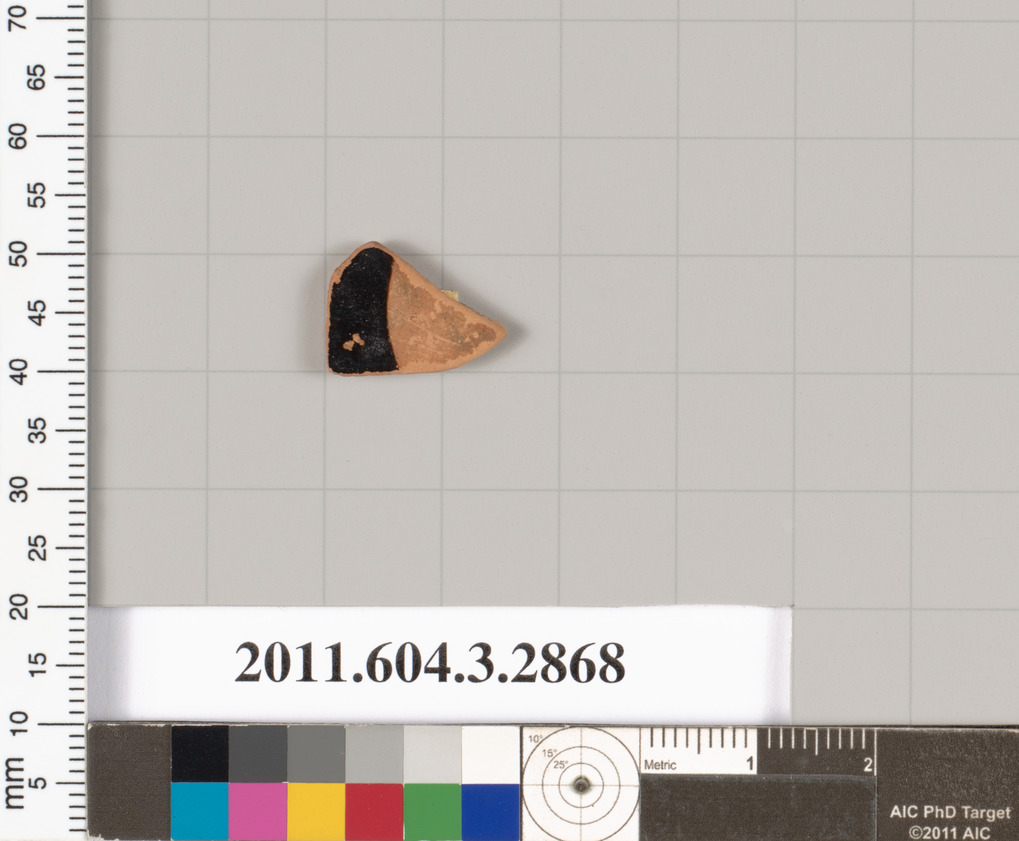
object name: undetermined shape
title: Terracotta fragment of an undetermined shape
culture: greek, attic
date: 600-401 BCE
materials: terracotta